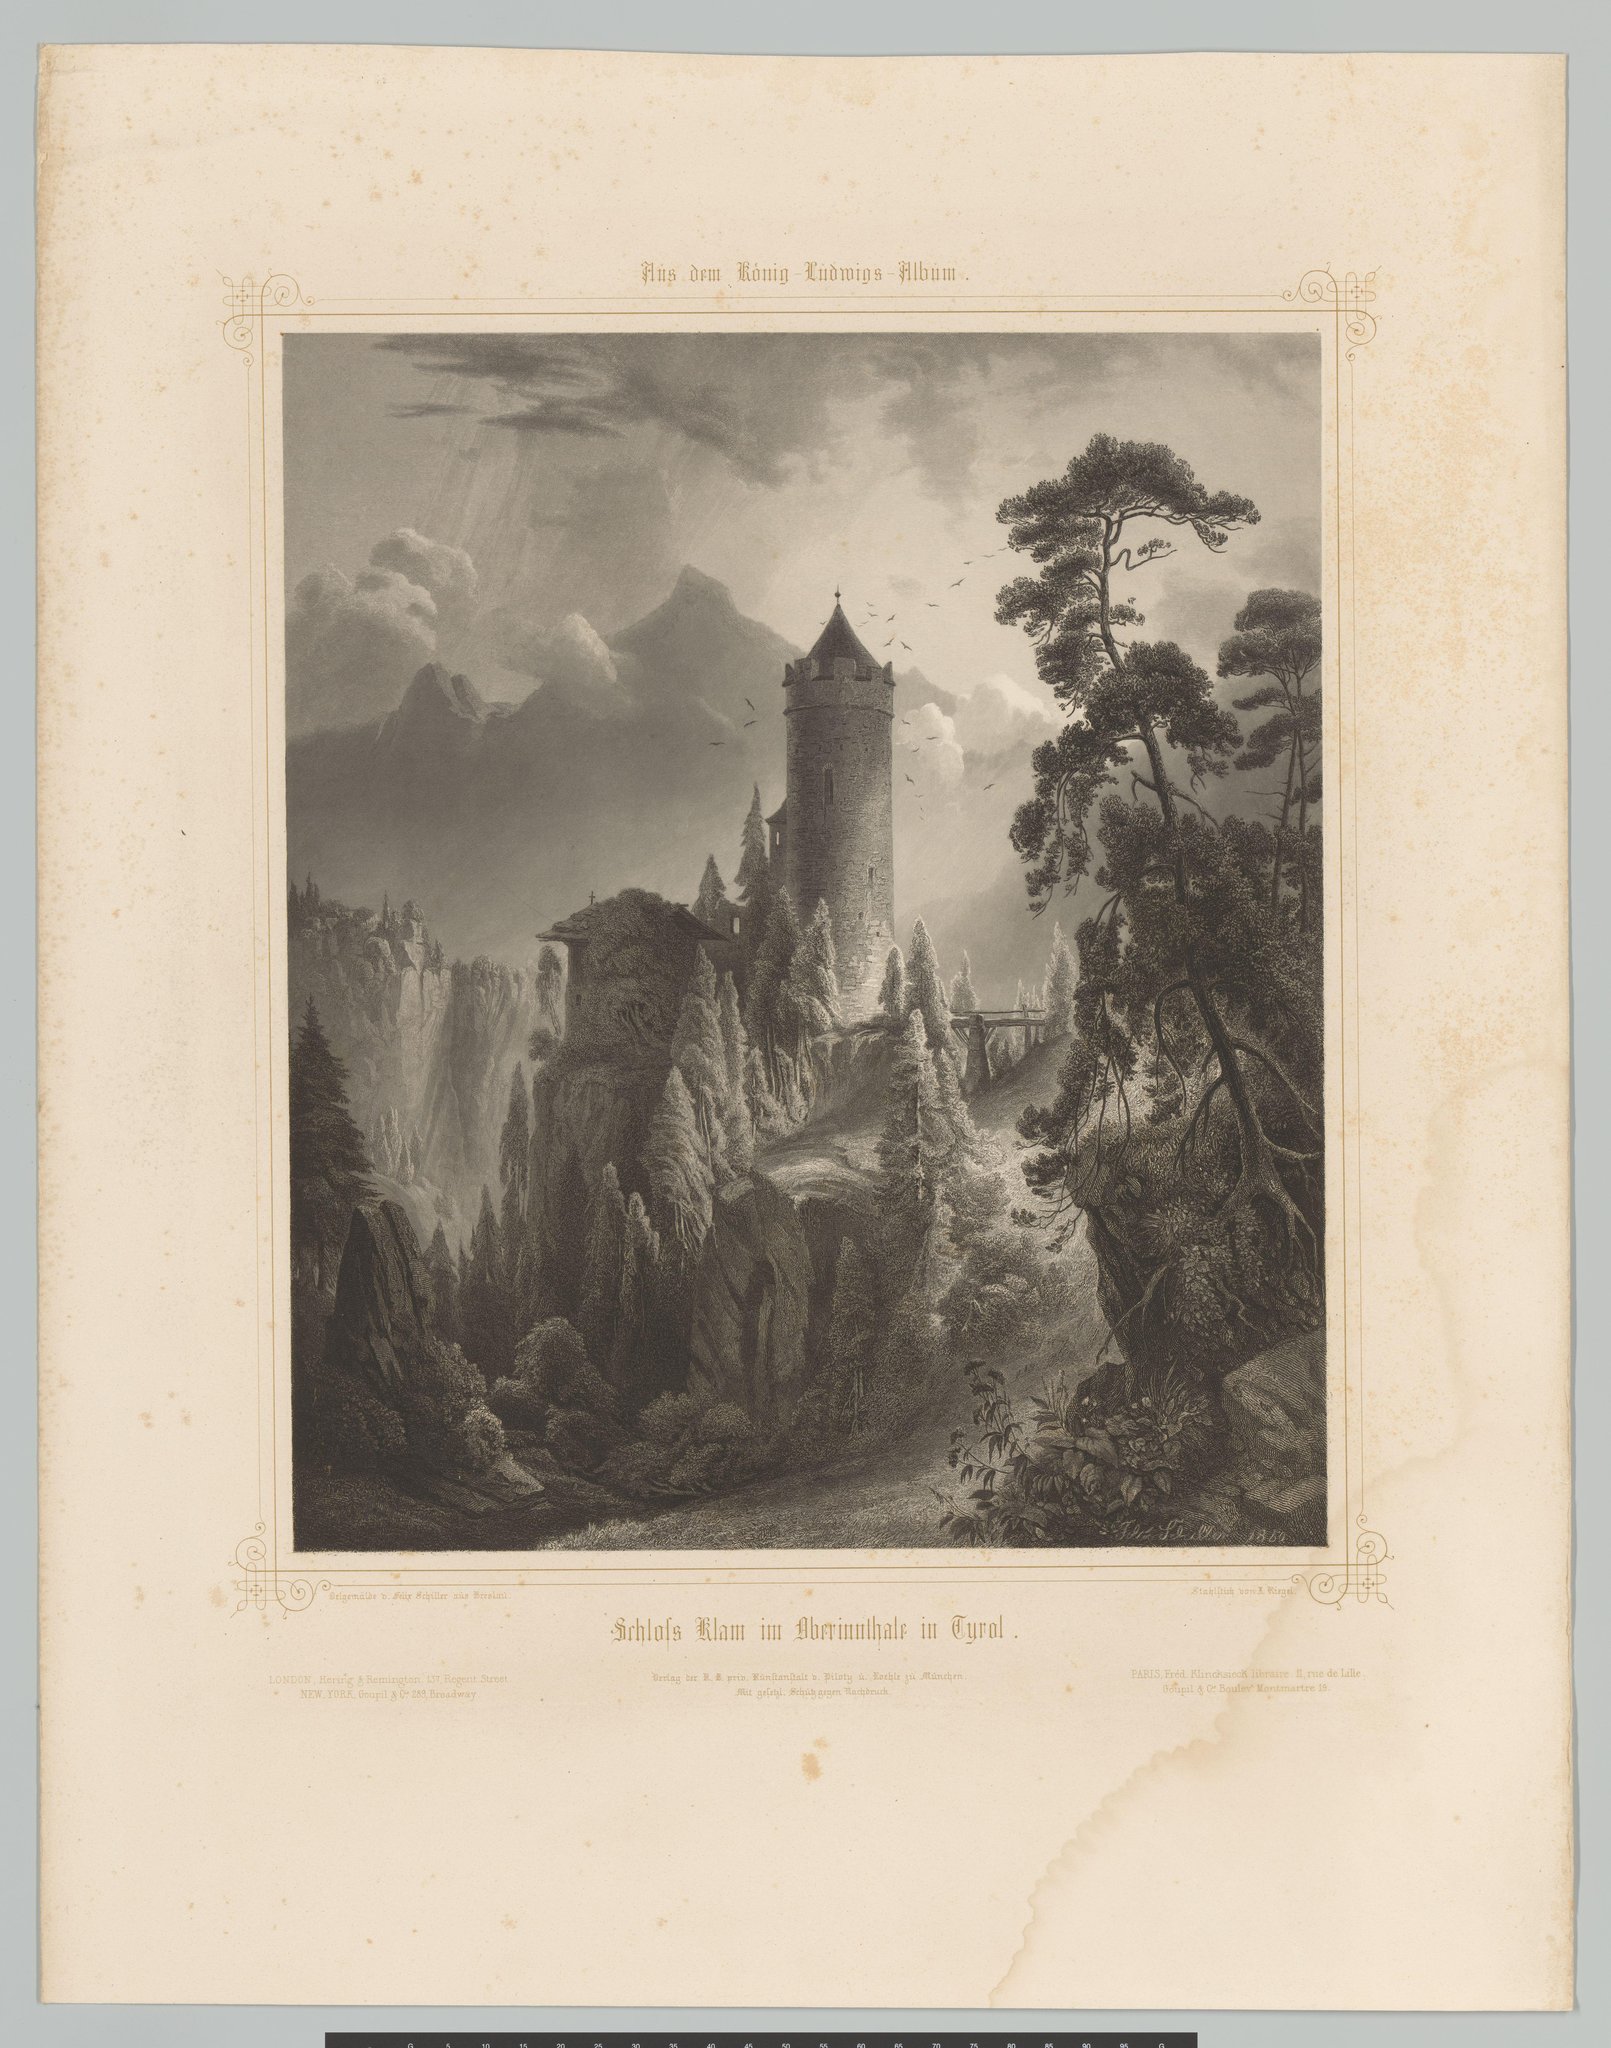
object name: print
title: Gezicht op kasteel Clam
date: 1850-1859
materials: paper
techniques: lithograph, engraving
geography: munich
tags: lodewijk i (koning van beieren), castle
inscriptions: collector's mark: Lugt 2228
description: Prent afkomstig uit de serie 'Album Seiner Majestät des Königs Ludwig I. von Bayern', verschenen in verschillende afleveringen. De prenten gaan terug op het album dat Lodewijk I van Beieren op 9 oktober 1850 kreeg overhandigd van verschillende kunstenaars.